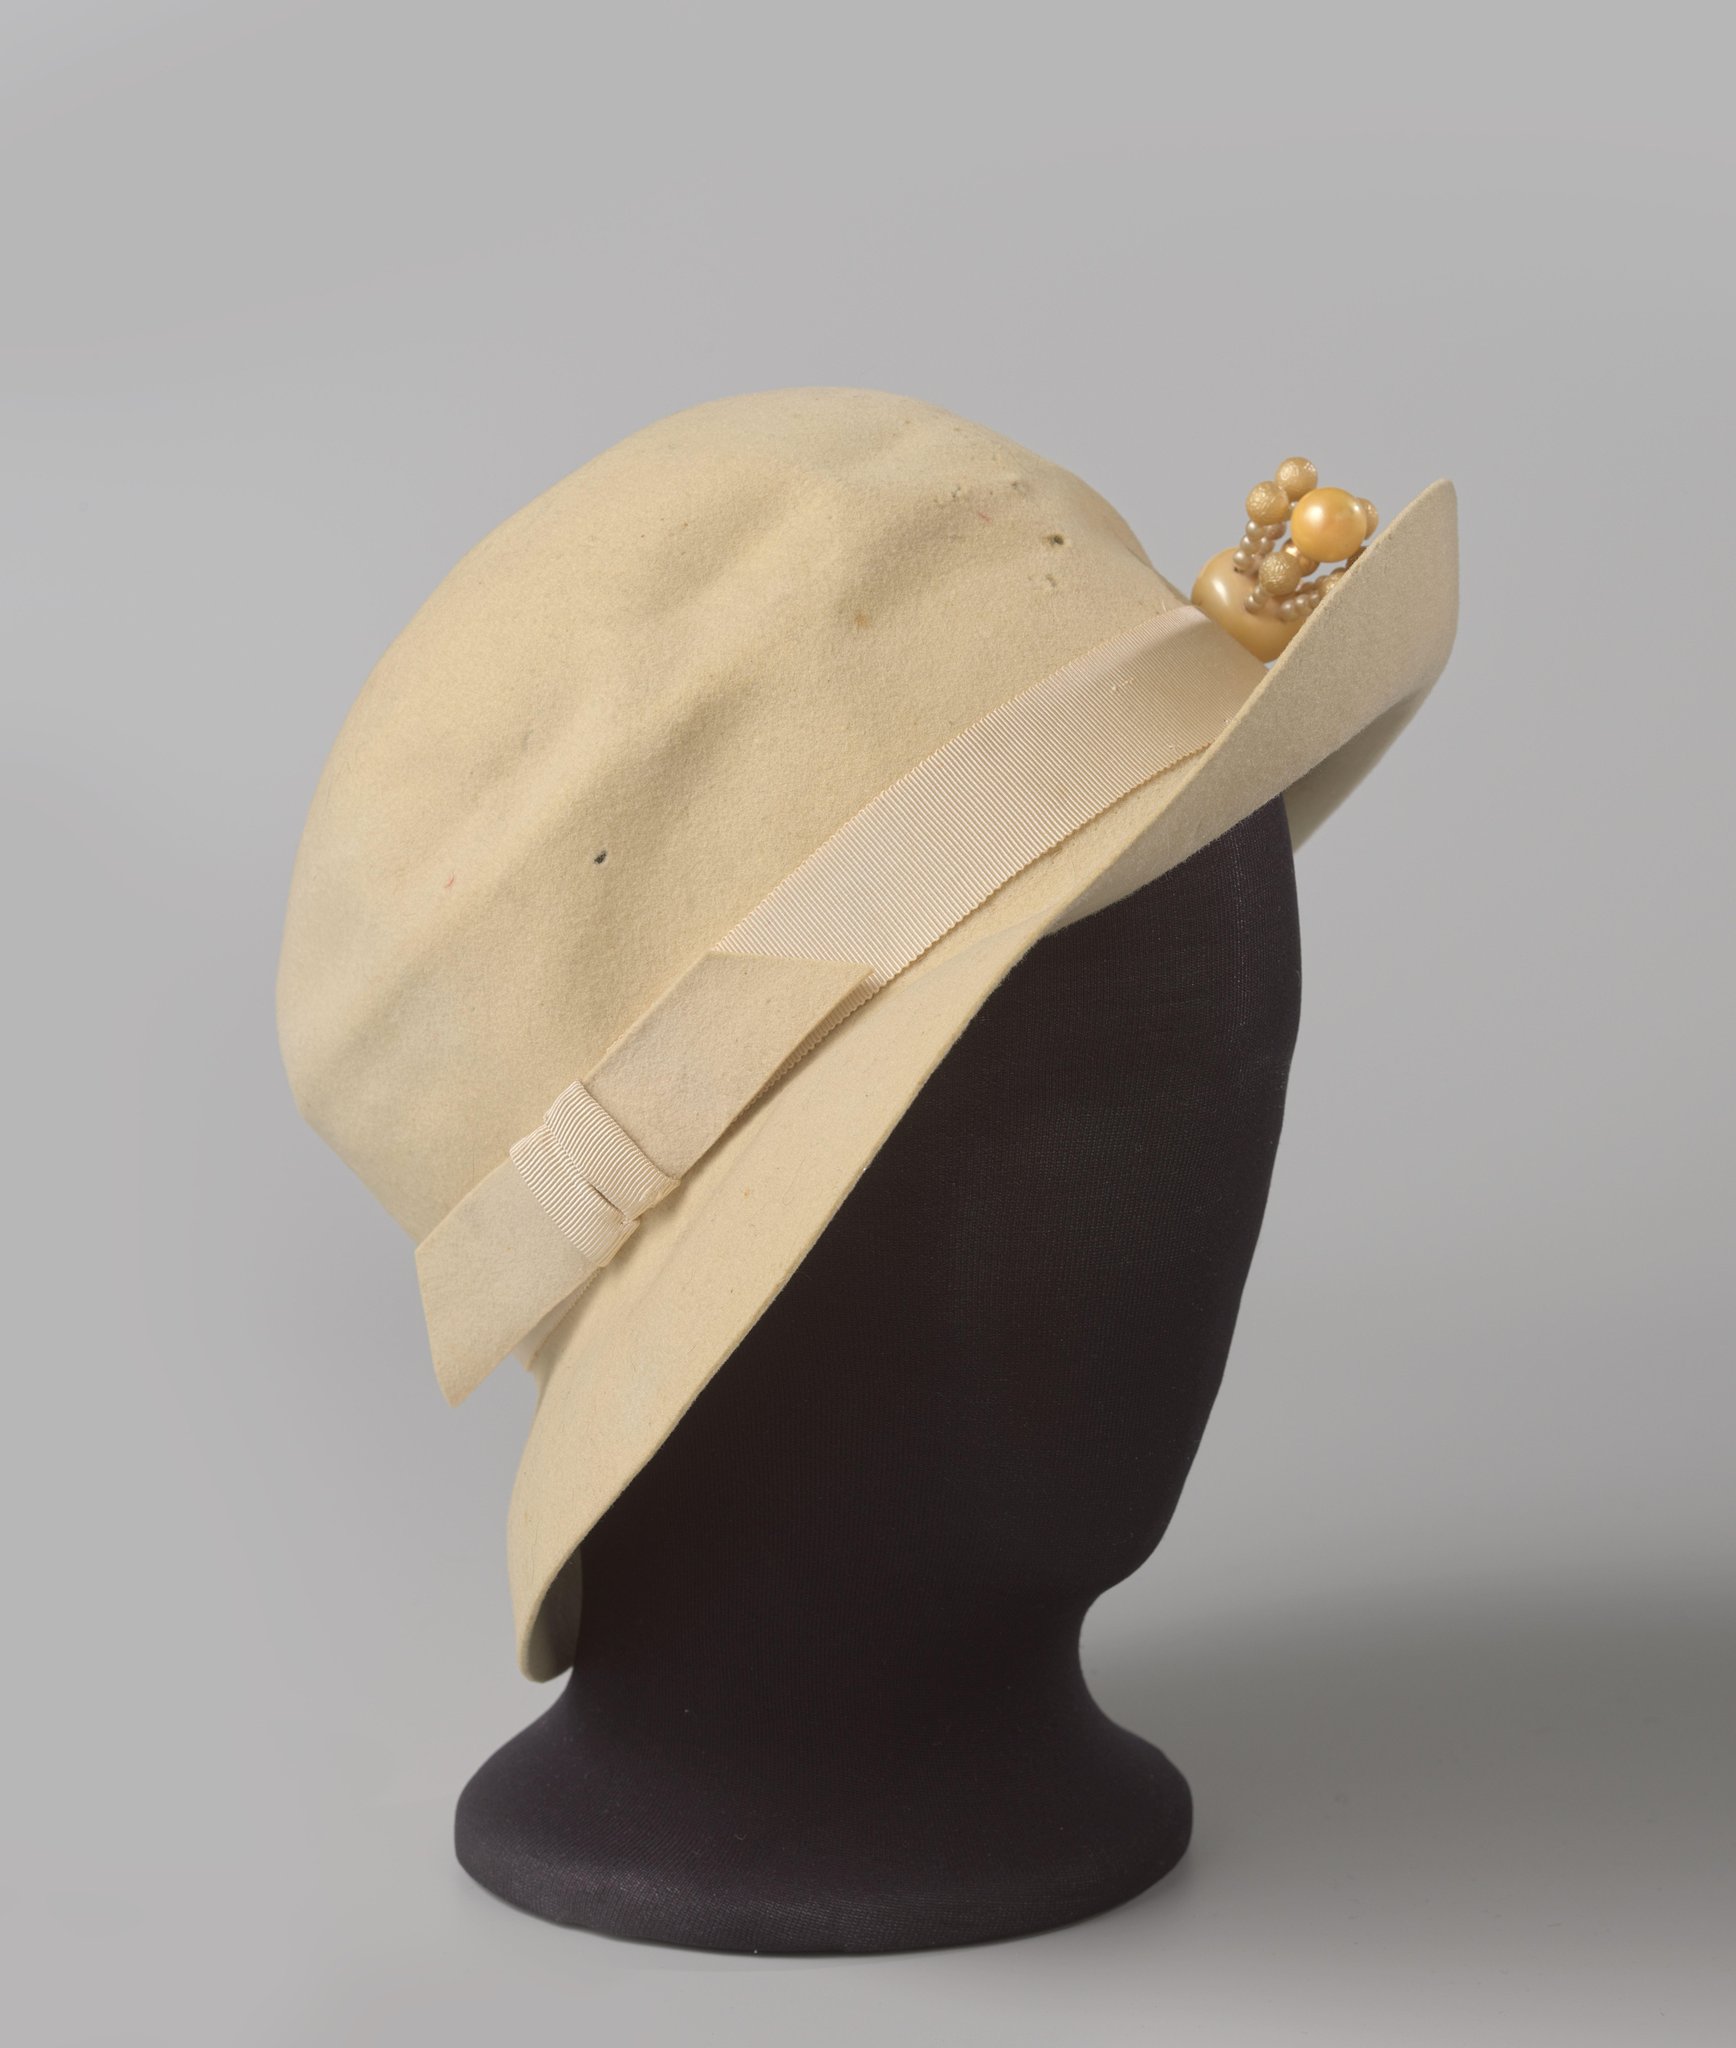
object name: womenswear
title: Hoed van soepel wit vilt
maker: Anonymous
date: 1940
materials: felt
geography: netherlands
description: Hoed van soepel wit vilt. Architectenmodel met cirkelplooi in de bol en uitstaande brede rand. Alleen een ripslint in wit versiert de bol.